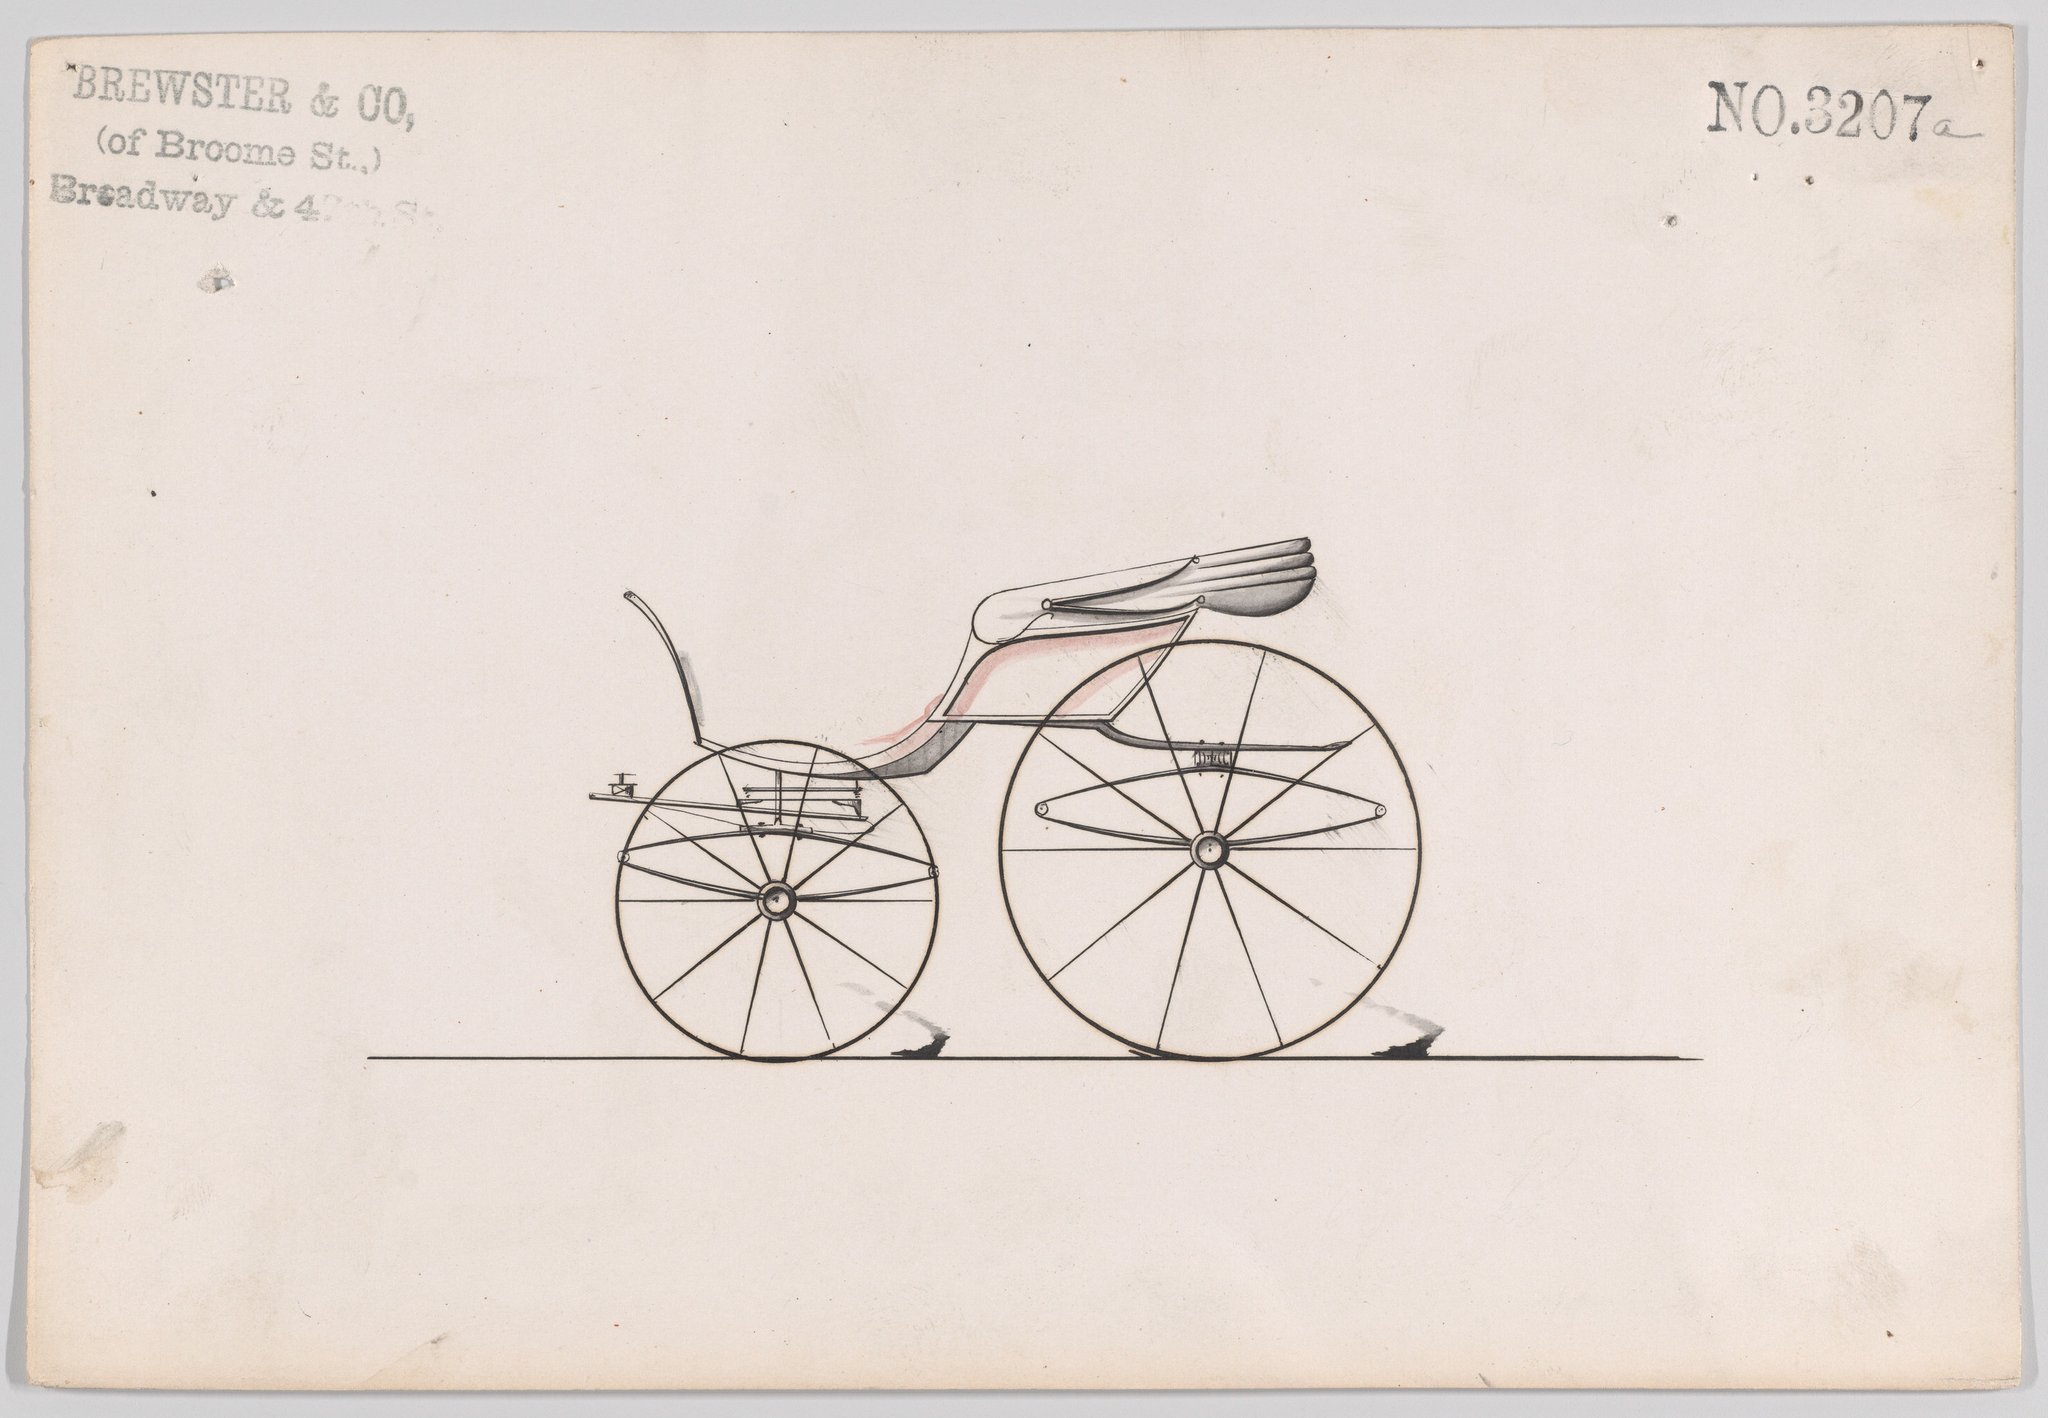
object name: drawing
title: Design for Pony Phaeton, no. 3207a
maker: brewster & co.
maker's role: manufacturer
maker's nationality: american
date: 1876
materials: gouache, ink, watercolor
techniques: pen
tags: carriages